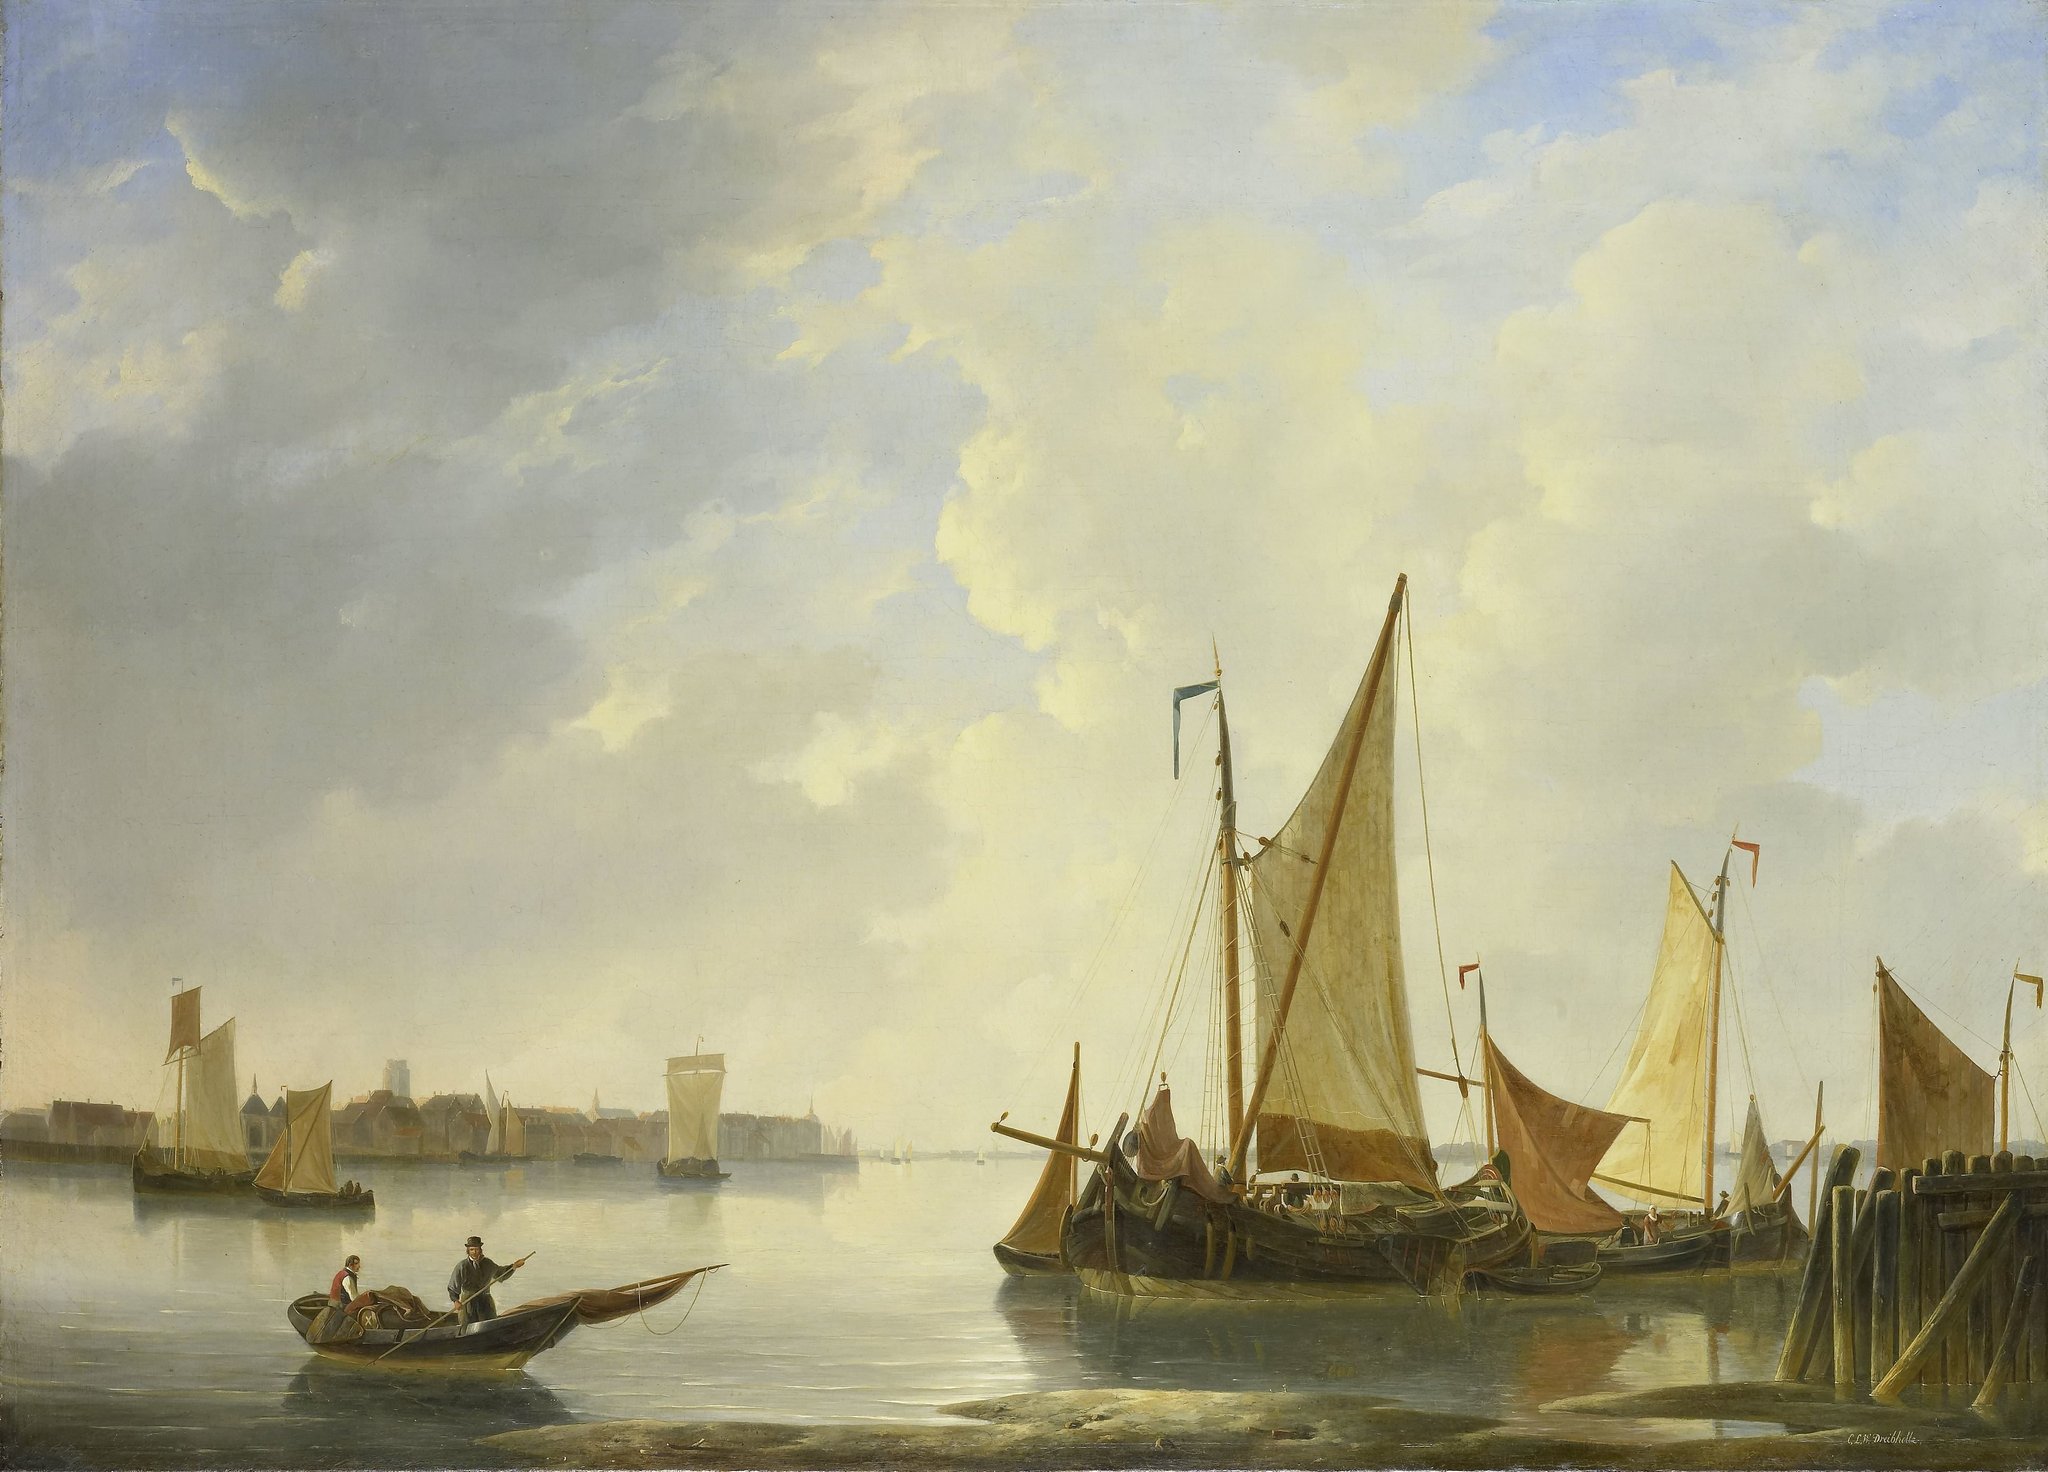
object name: painting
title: View of Dordrecht seen from Papendrecht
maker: christiaan lodewijk willem dreibholtz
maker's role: draughtsman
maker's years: 1799-1874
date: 1830-1837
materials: canvas, oil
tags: sailing-ship, sailing-boat, river, prospect of city, town panorama, silhouette of city, dordrecht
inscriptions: signature: ‘C.L.W. Dreibholtz’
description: Gezicht op Dordrecht over het water vanaf Papendrecht. Rechts enige vissersschepen.